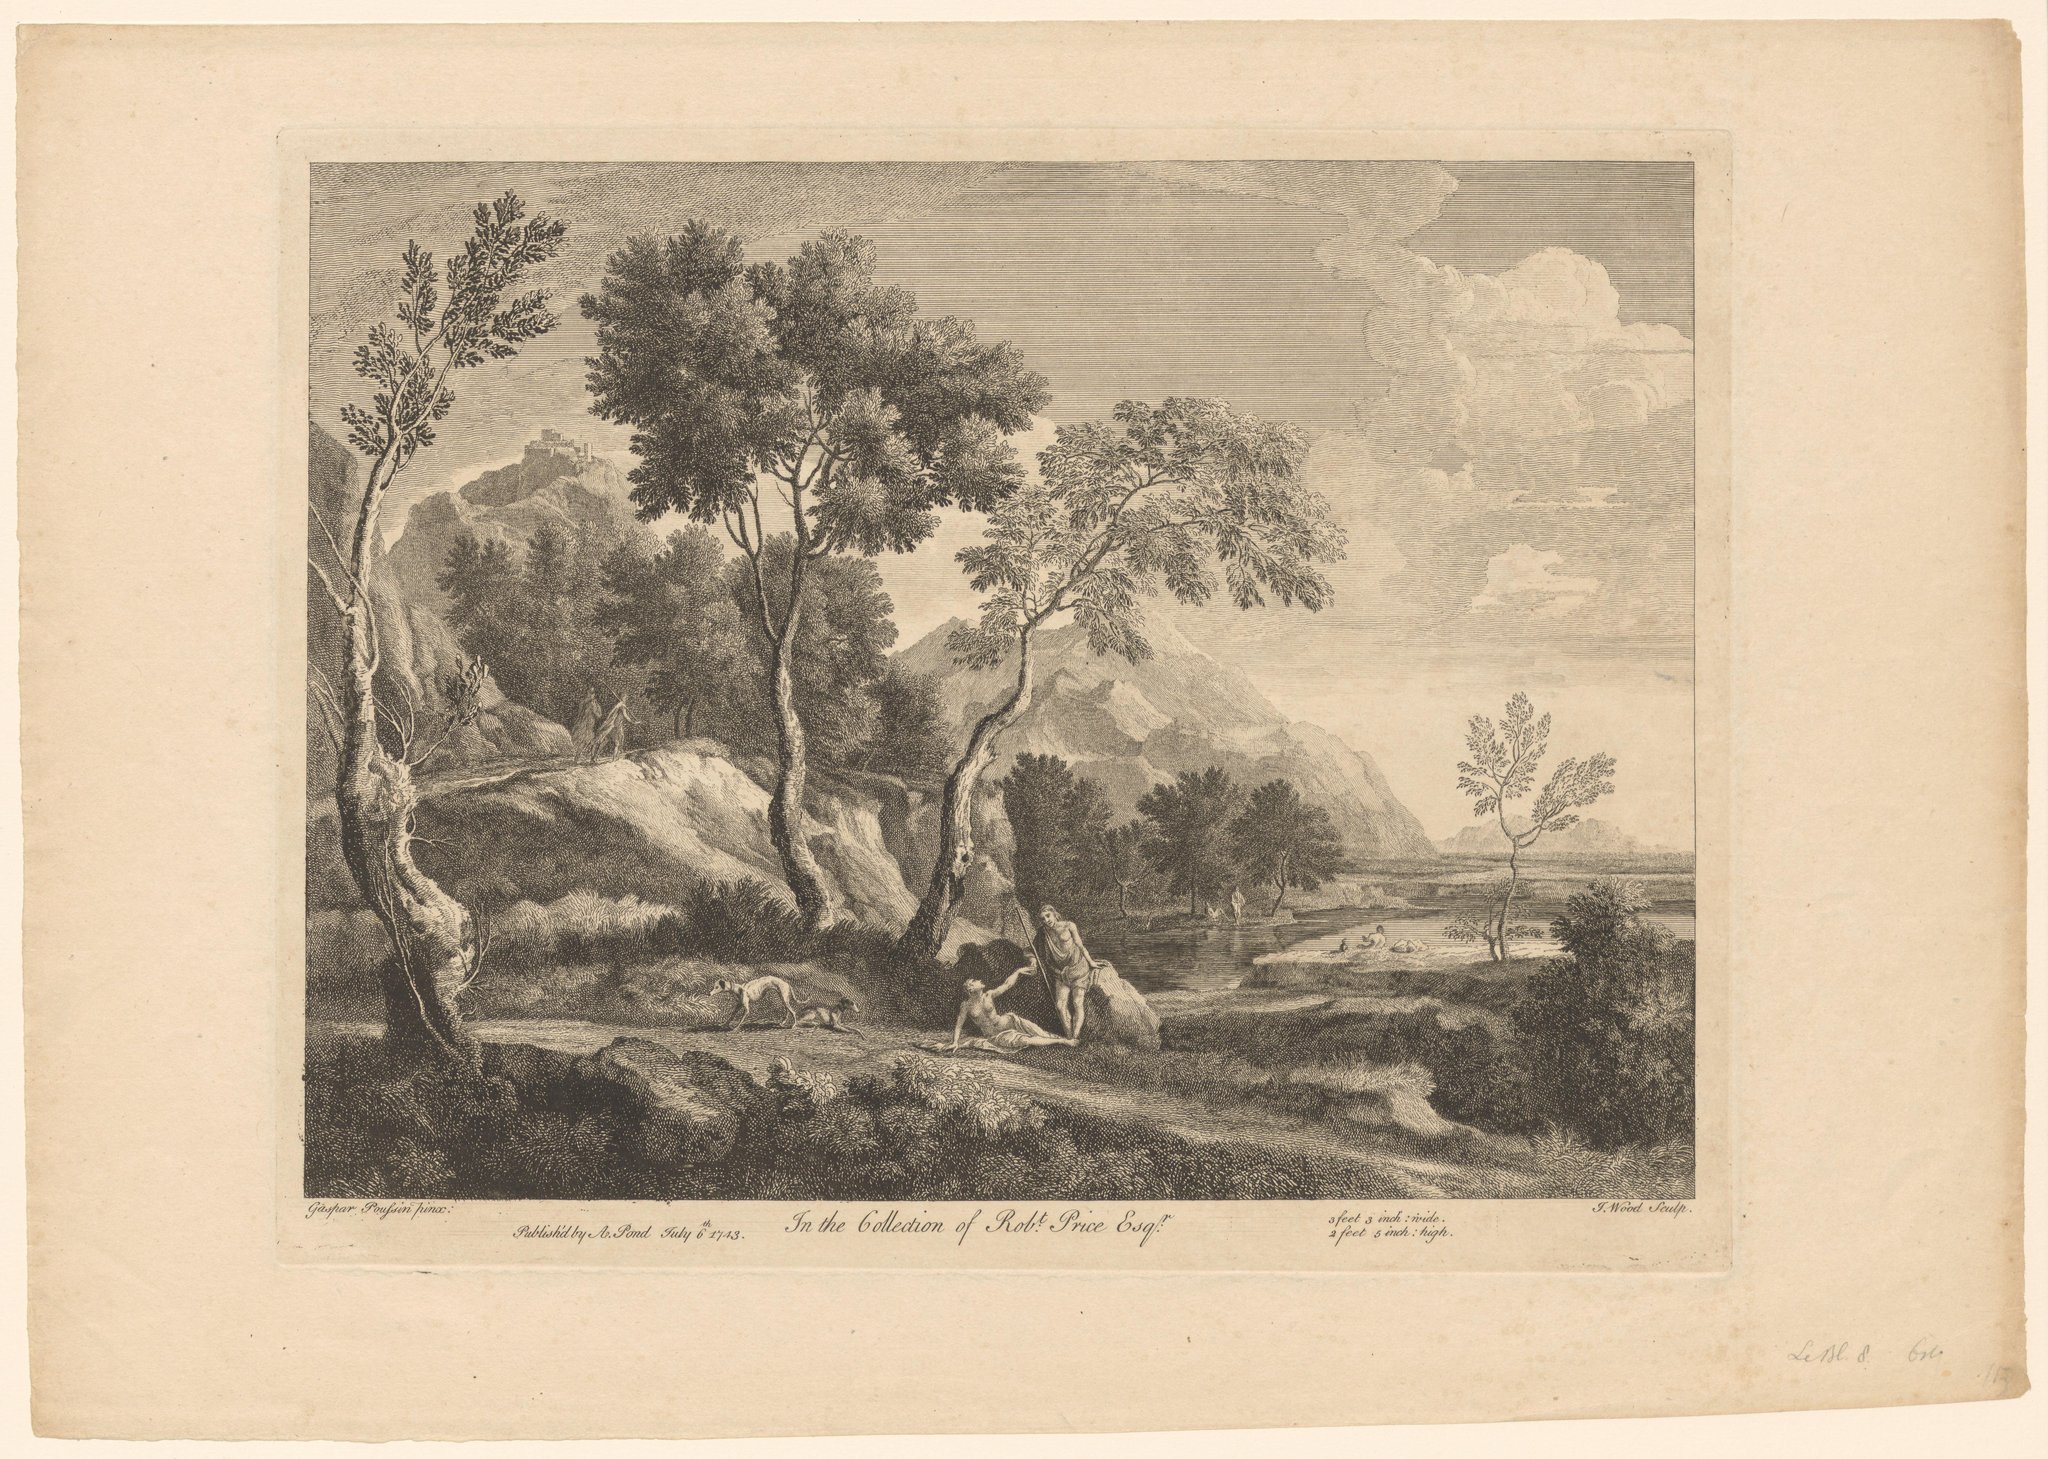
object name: print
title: Bergachtig landschap met zeven figuren en twee honden aan een oever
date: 1707-1743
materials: paper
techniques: etching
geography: london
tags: draughtsman, robert price, river bank, dog, mountains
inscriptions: collector's mark: Lugt 2228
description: De serie werd tussen 1741 en 1746 door Knapton en Pond uitgegeven, en gemaakt door verschillende prentmakers.